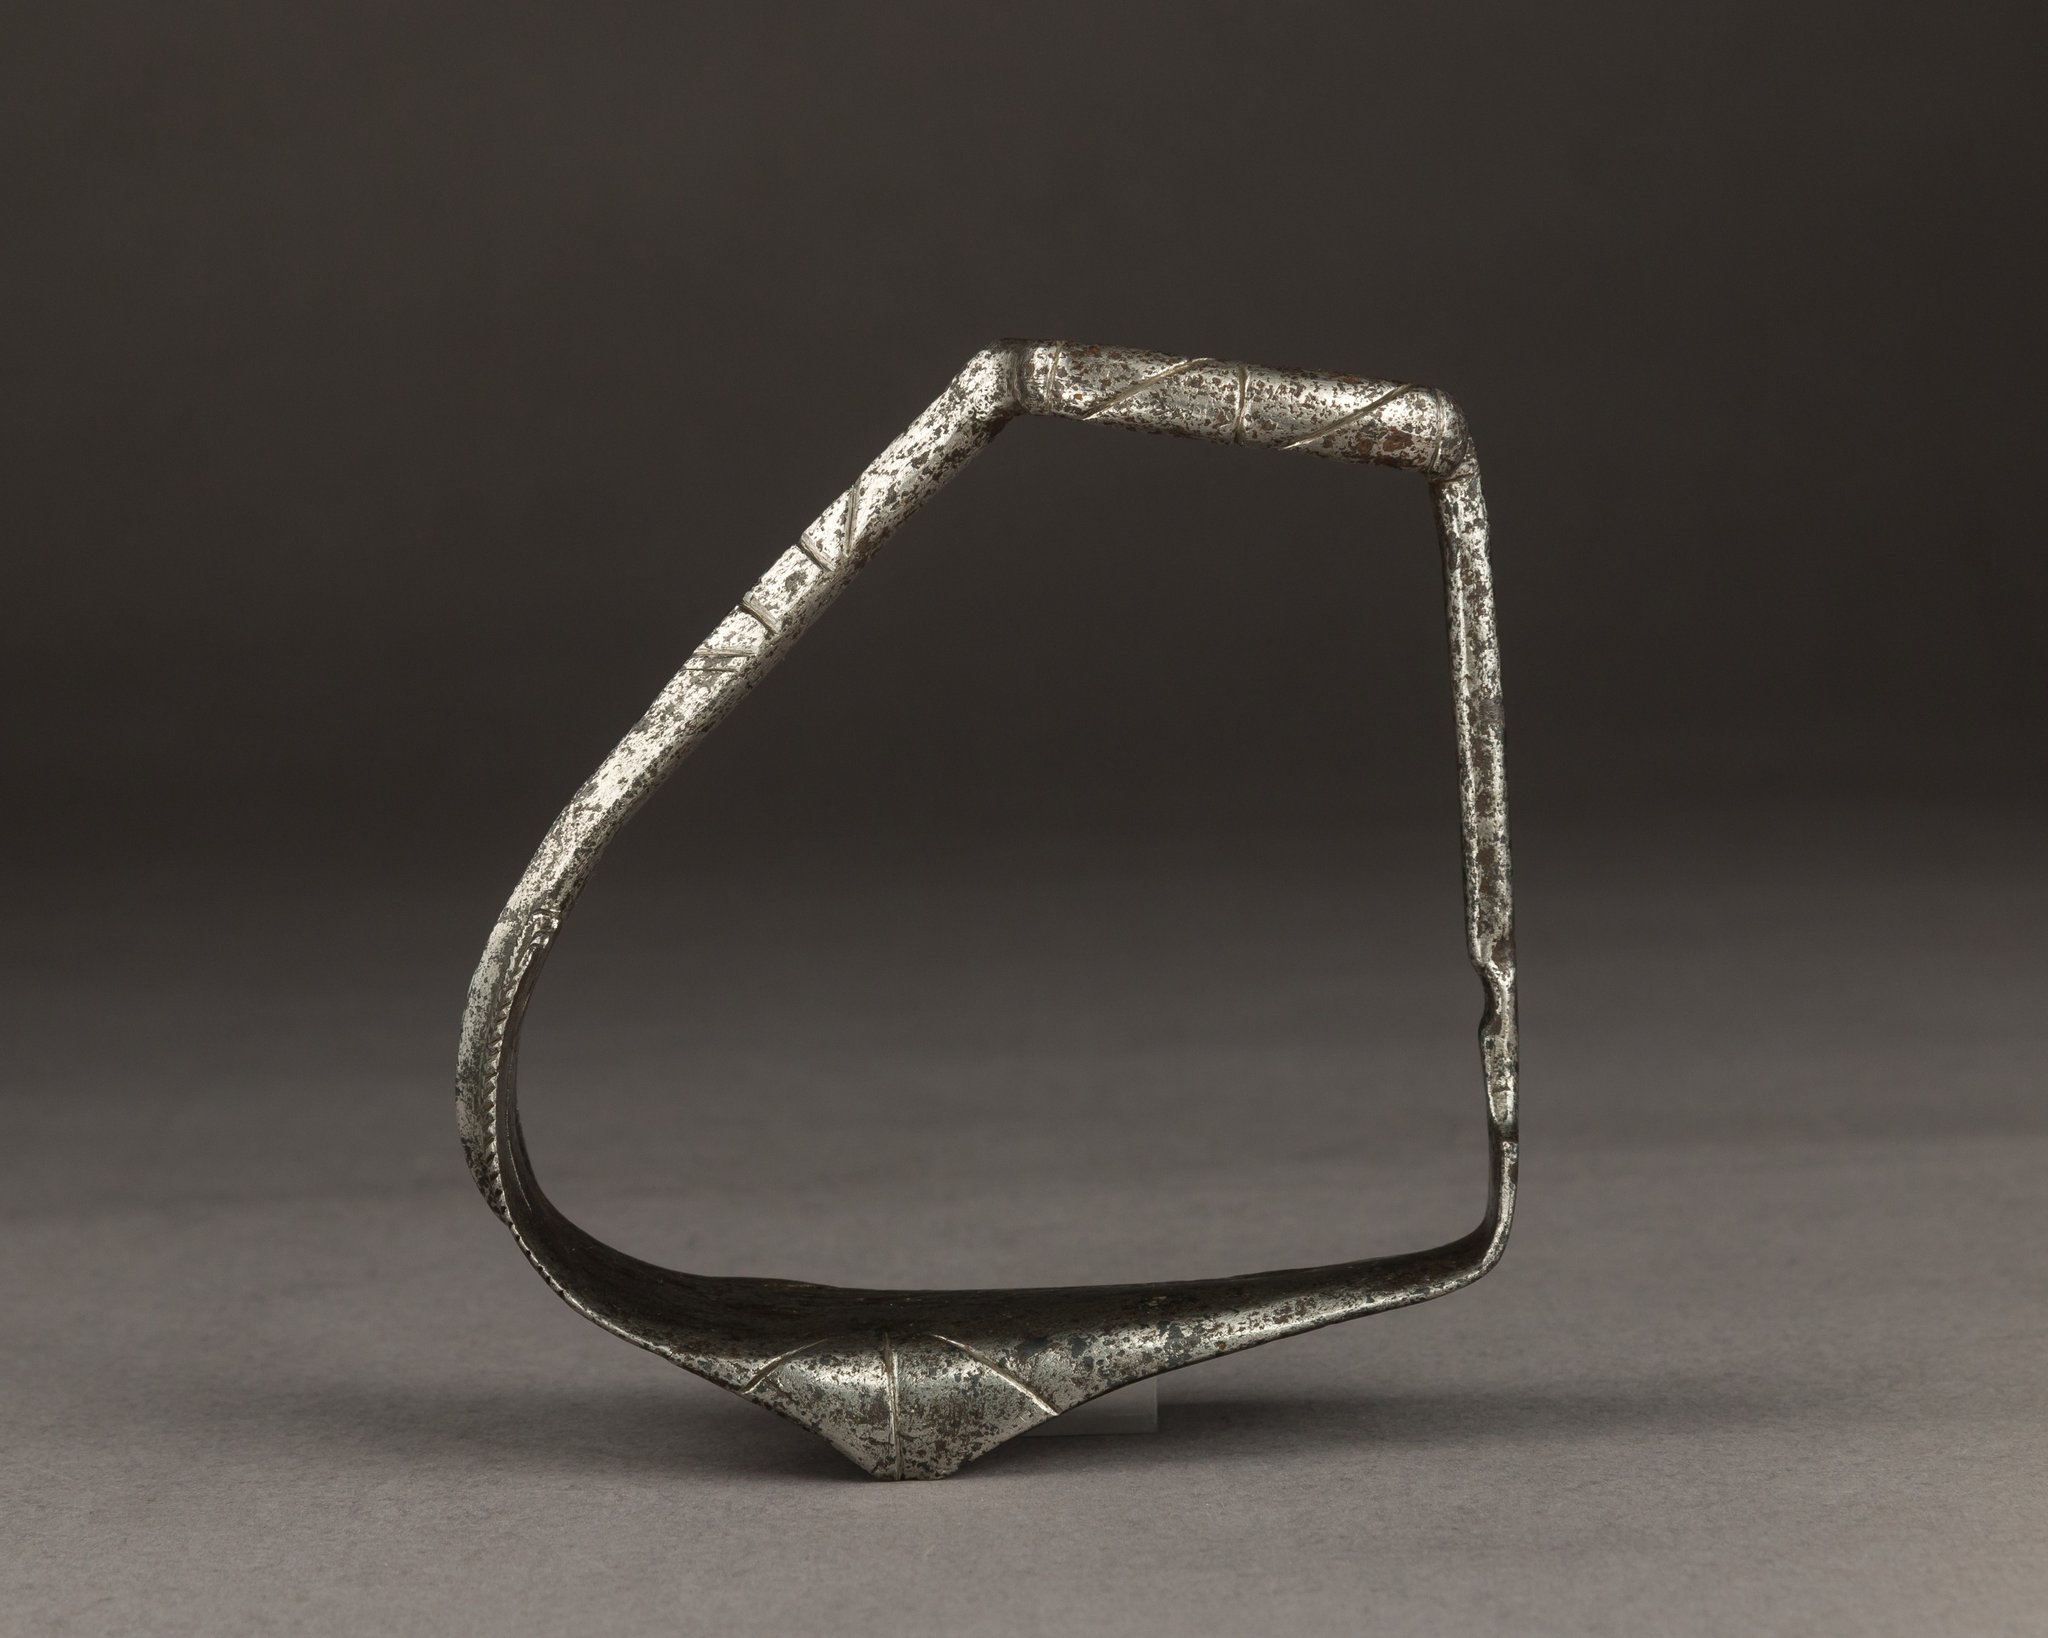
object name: stirrup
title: Pair of Stirrups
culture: bohemian or german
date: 1401-1450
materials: iron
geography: czech republic